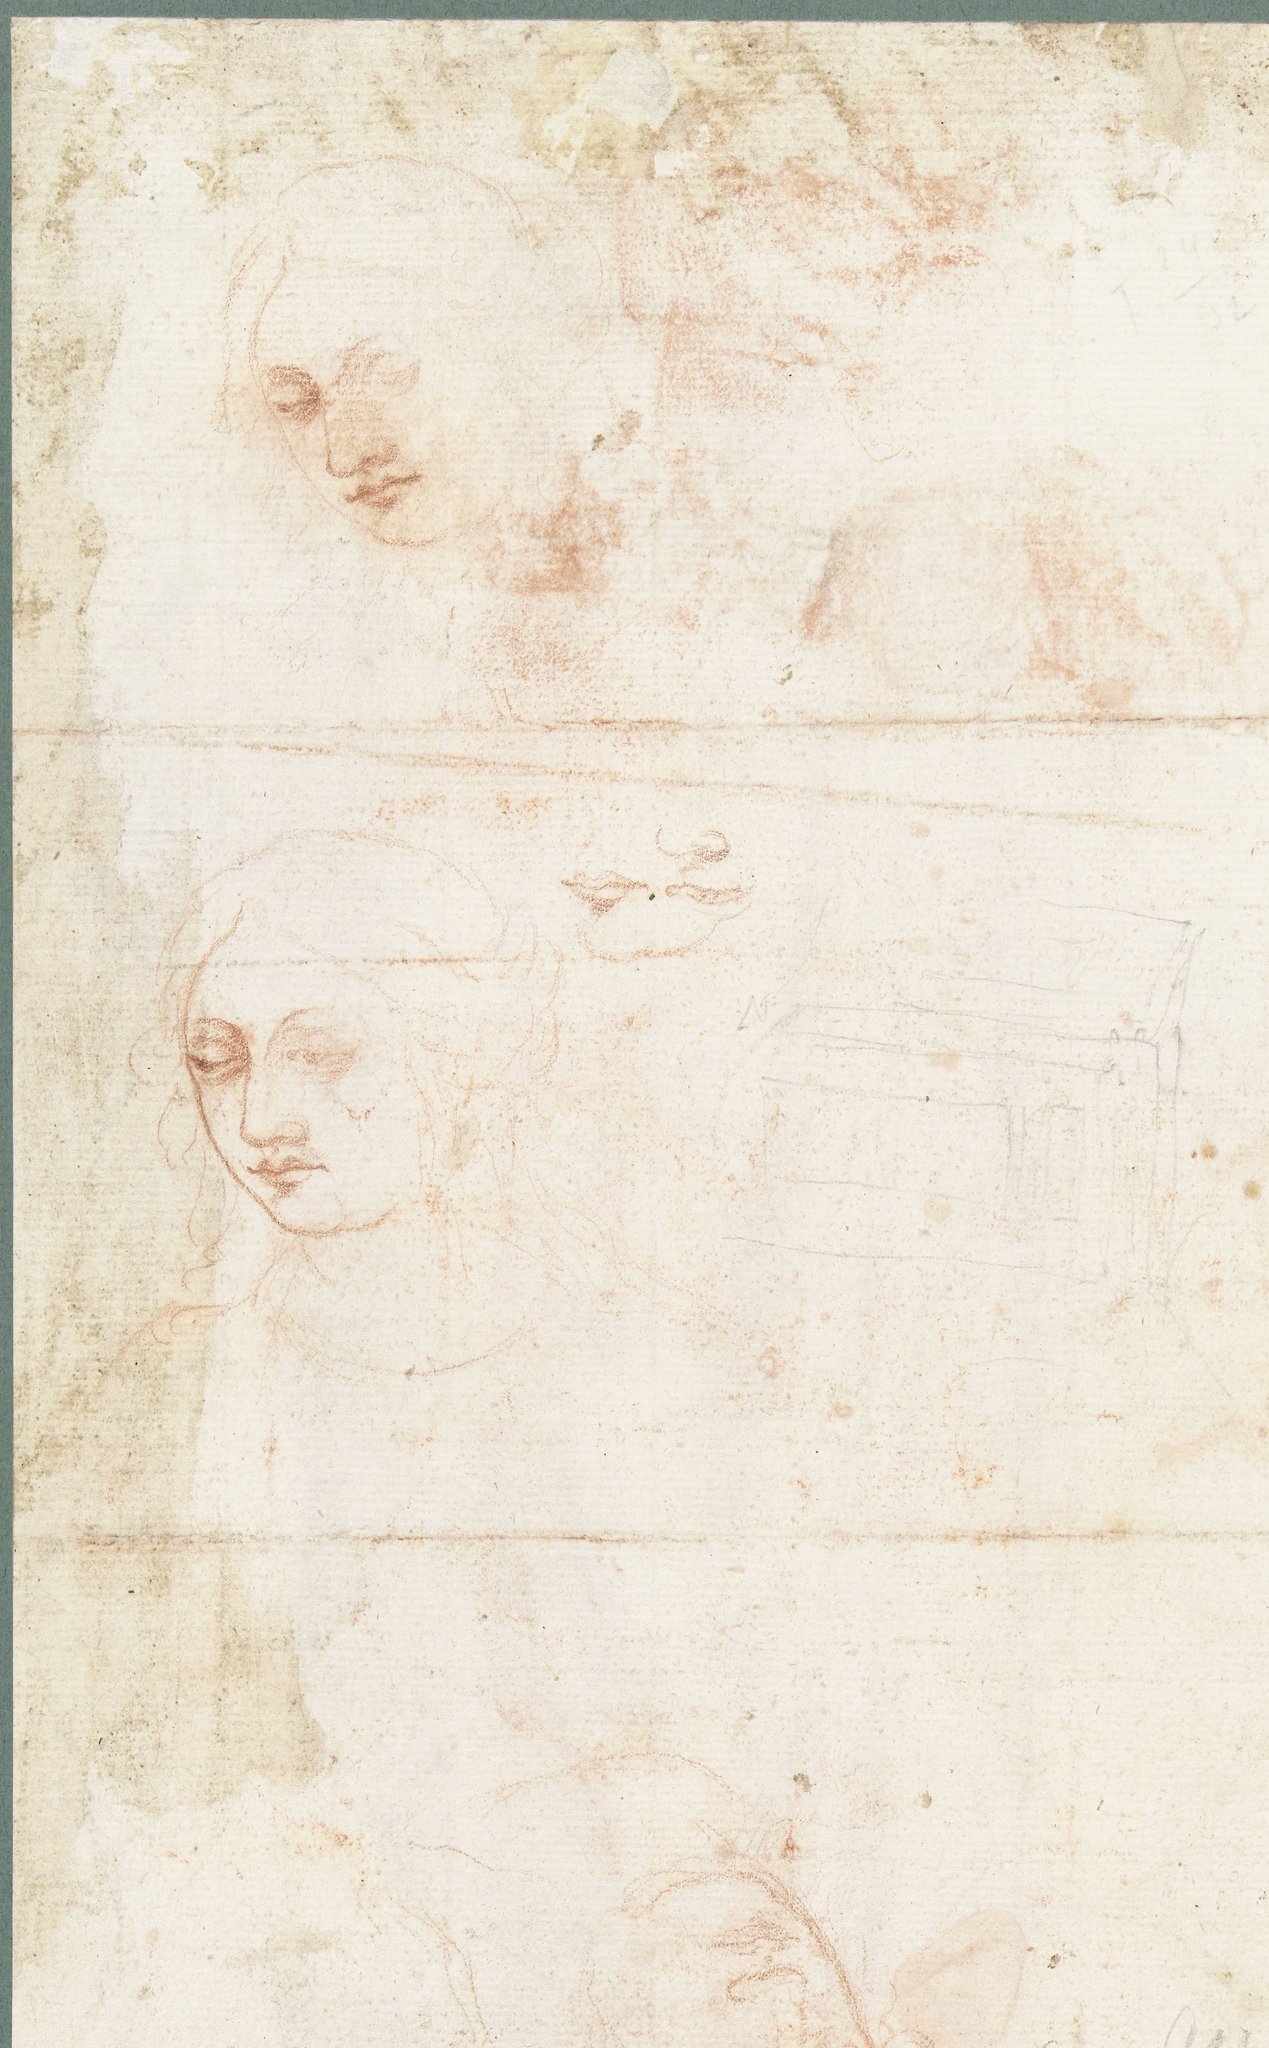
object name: drawing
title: Enige vrouwenhoofden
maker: girolamo muziano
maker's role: draughtsman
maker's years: 1528-1592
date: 1538-1592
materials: chalk, paper